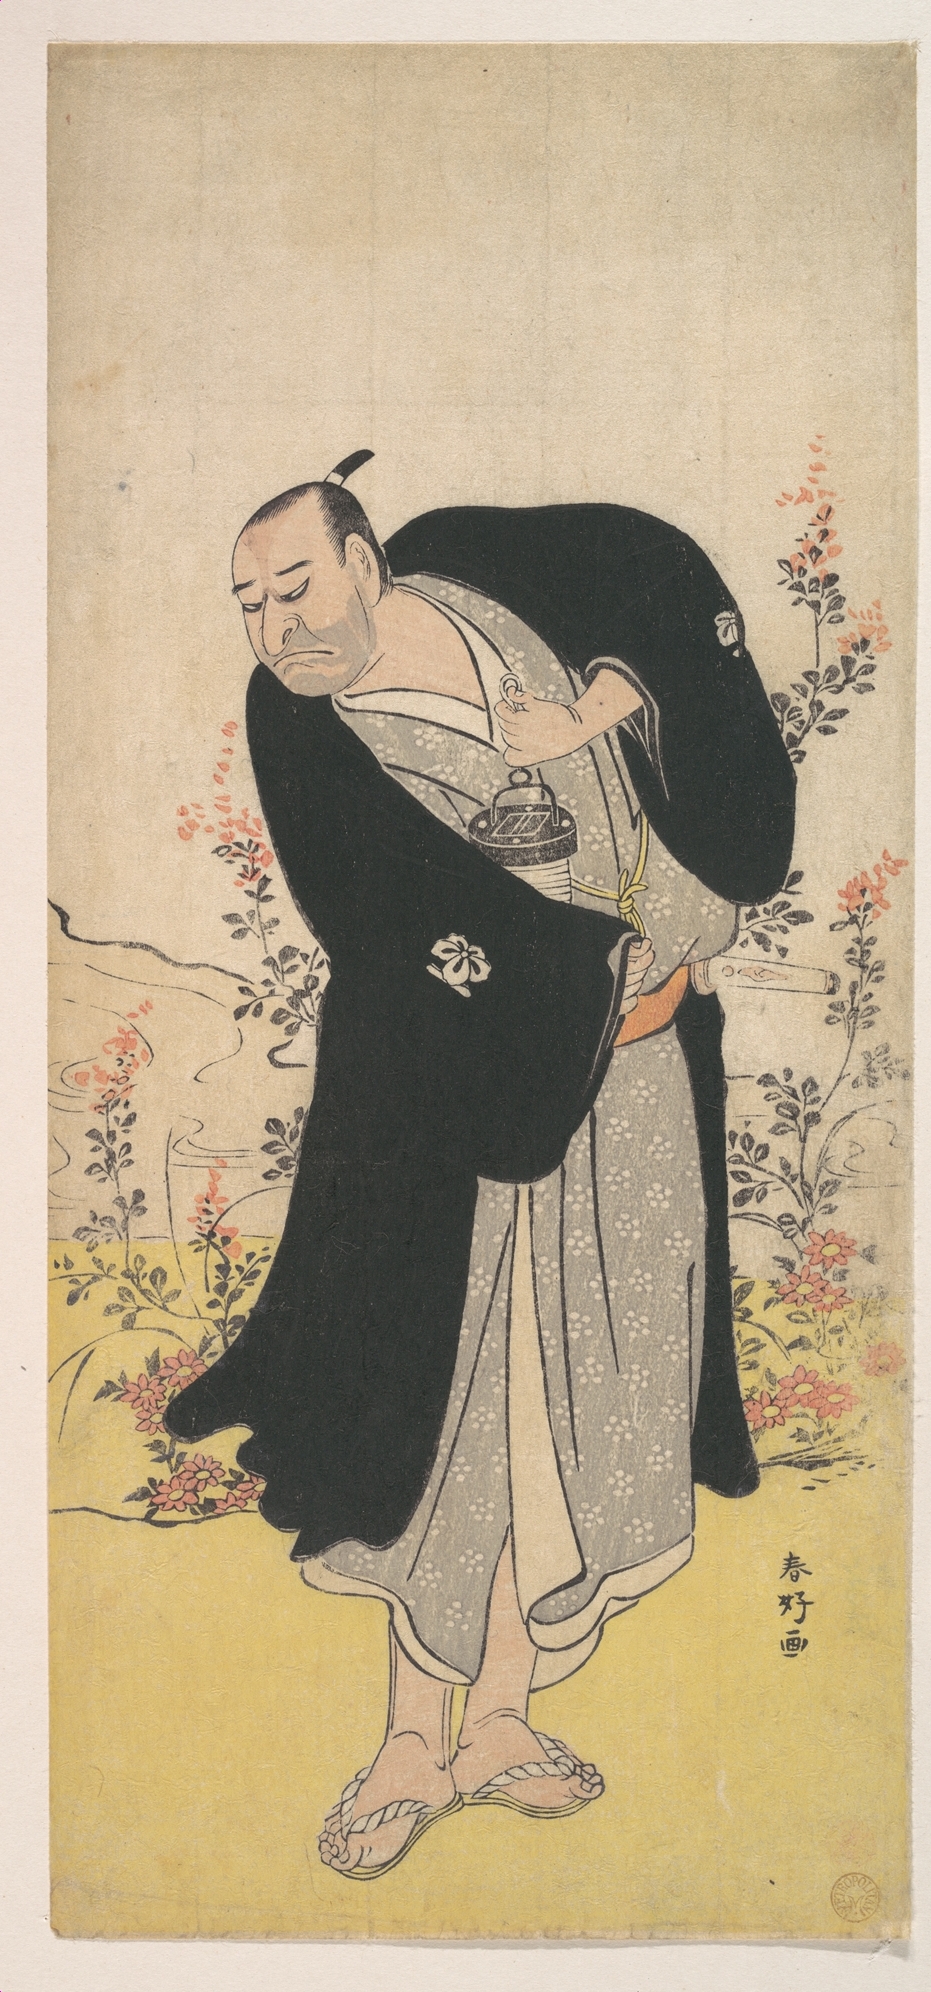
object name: print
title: Kabuki Actor Nakayama Kojūrō VI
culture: japanese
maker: katsukawa shunkō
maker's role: artist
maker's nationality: japanese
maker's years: 1743-1812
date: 1786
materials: ink, paper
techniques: woodblock print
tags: men,actors